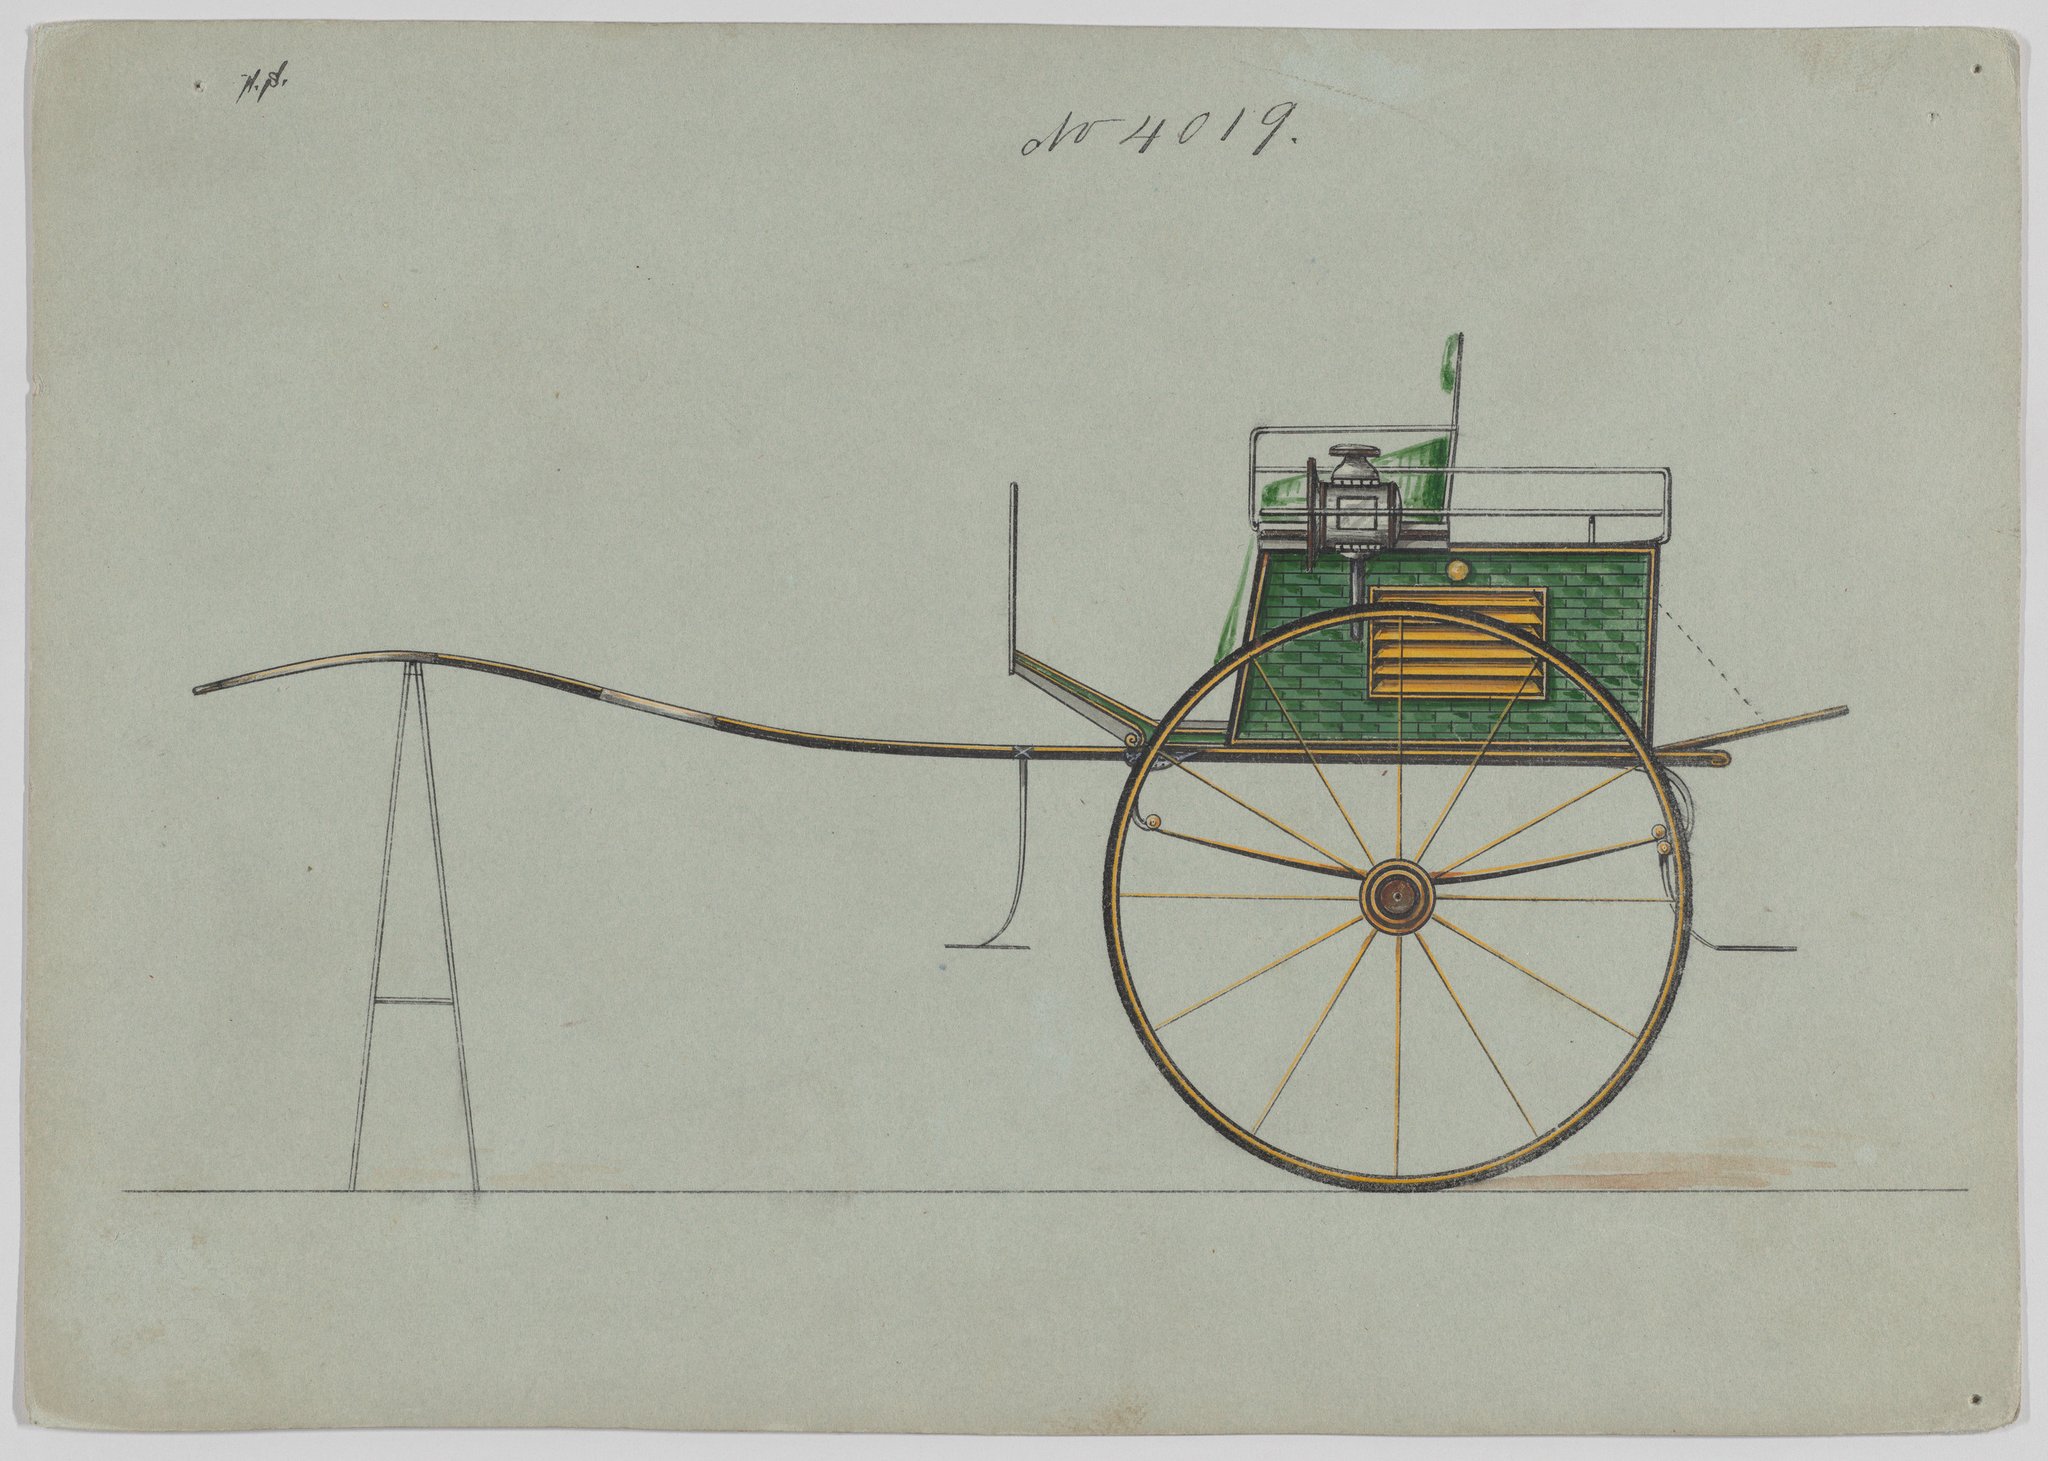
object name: drawing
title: Design for Dog Cart or 2 Wheeler, no. 4019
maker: brewster & co.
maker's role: manufacturer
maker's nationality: american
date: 1888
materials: gouache, gum arabic, ink, watercolor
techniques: pen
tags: carriages